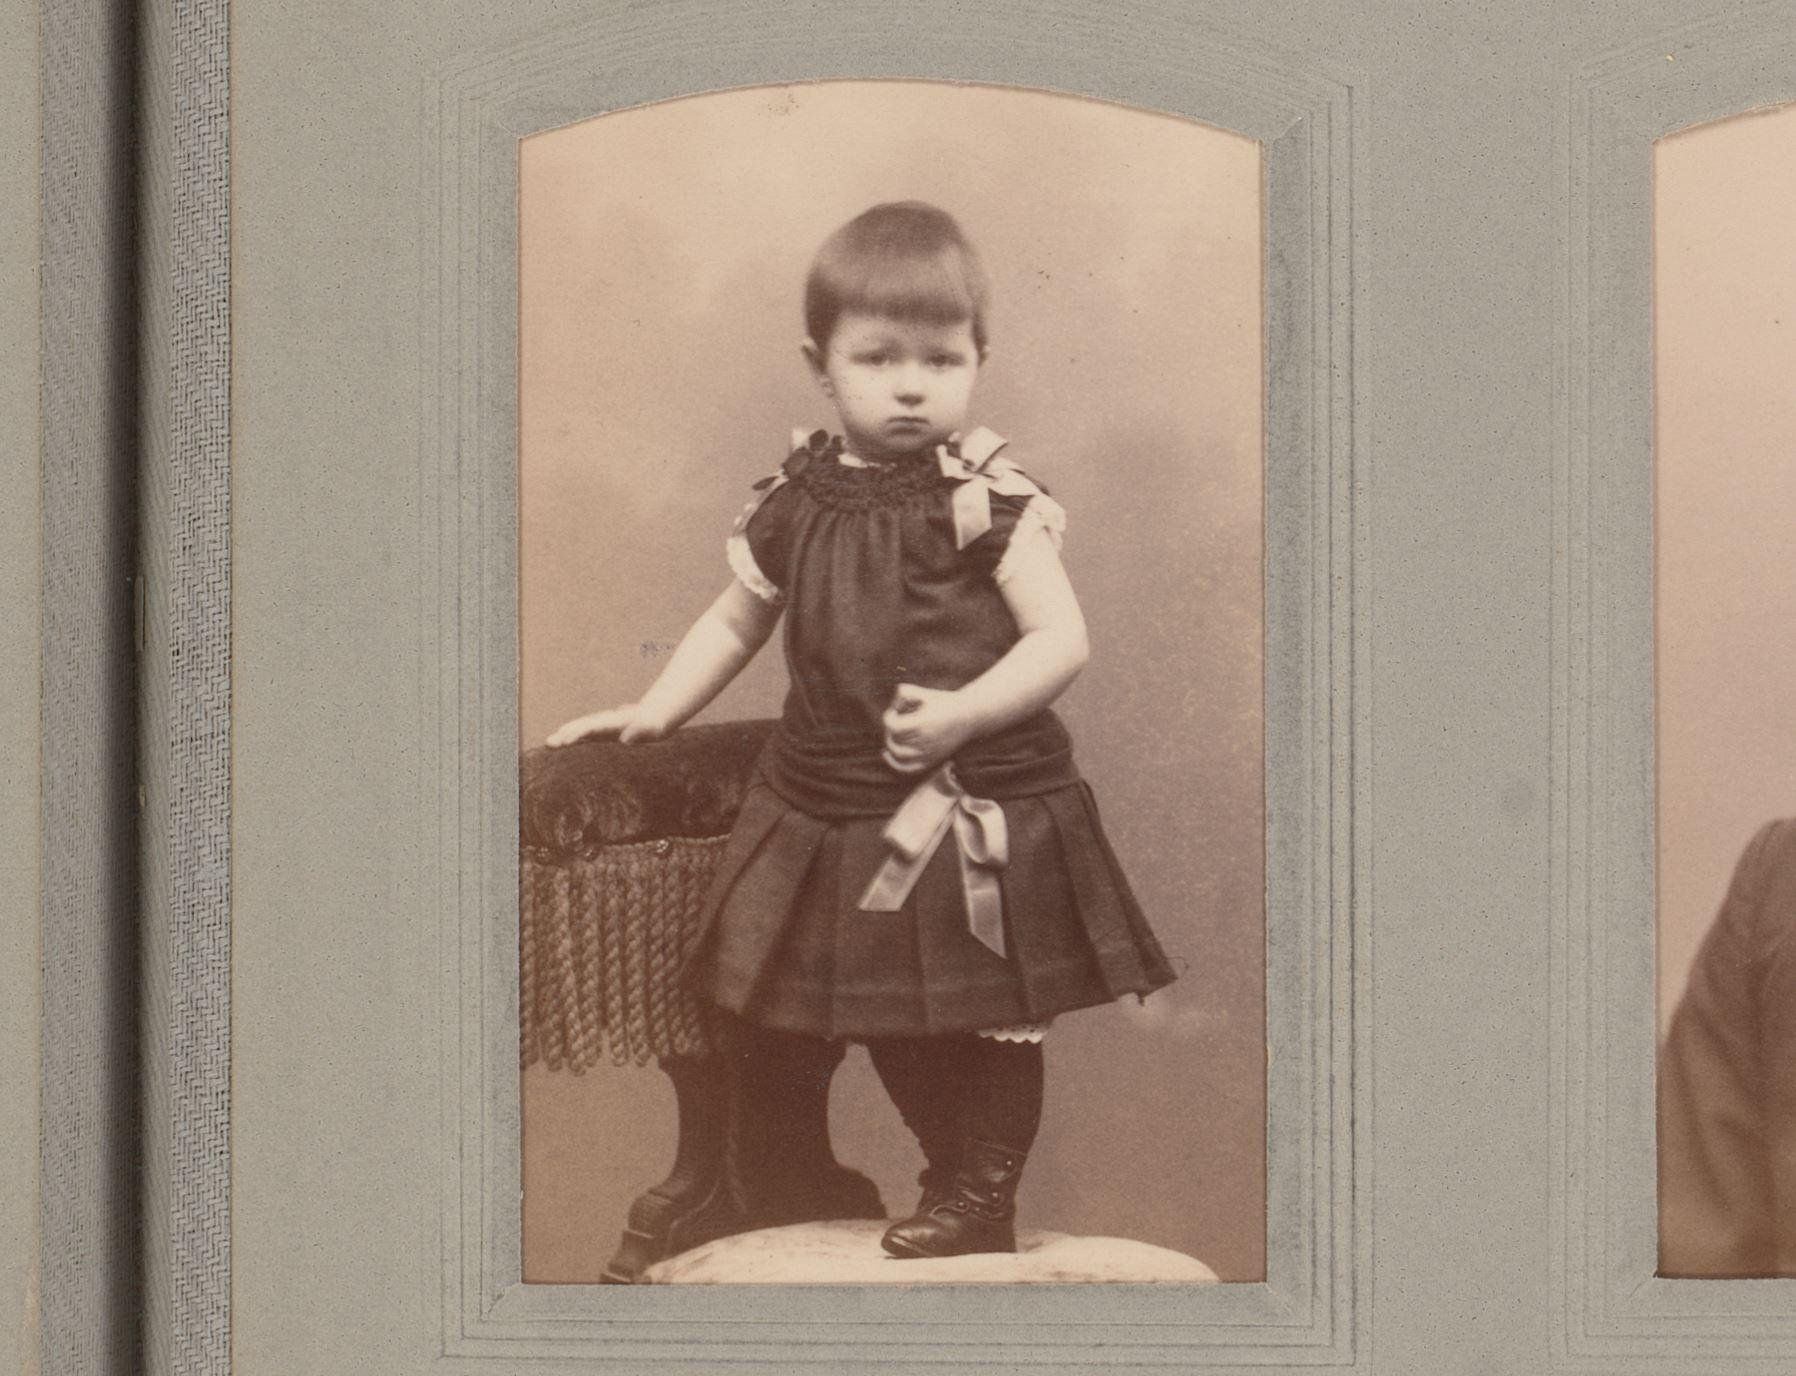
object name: album leaf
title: Portret van een meisje, staand op een stoel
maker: fr. schulz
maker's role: fotograaf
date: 1860-1900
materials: cardboard, photographic support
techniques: albumen print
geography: helsinki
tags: historical persons - bb - woman, toddler (female), standing figure - aa - female human figure, chair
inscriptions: inscription: ‘Fr. Schulz/ HELSINGFORS/ 24 Vestra Henriksgatan 24/ Pläten förvaras.’